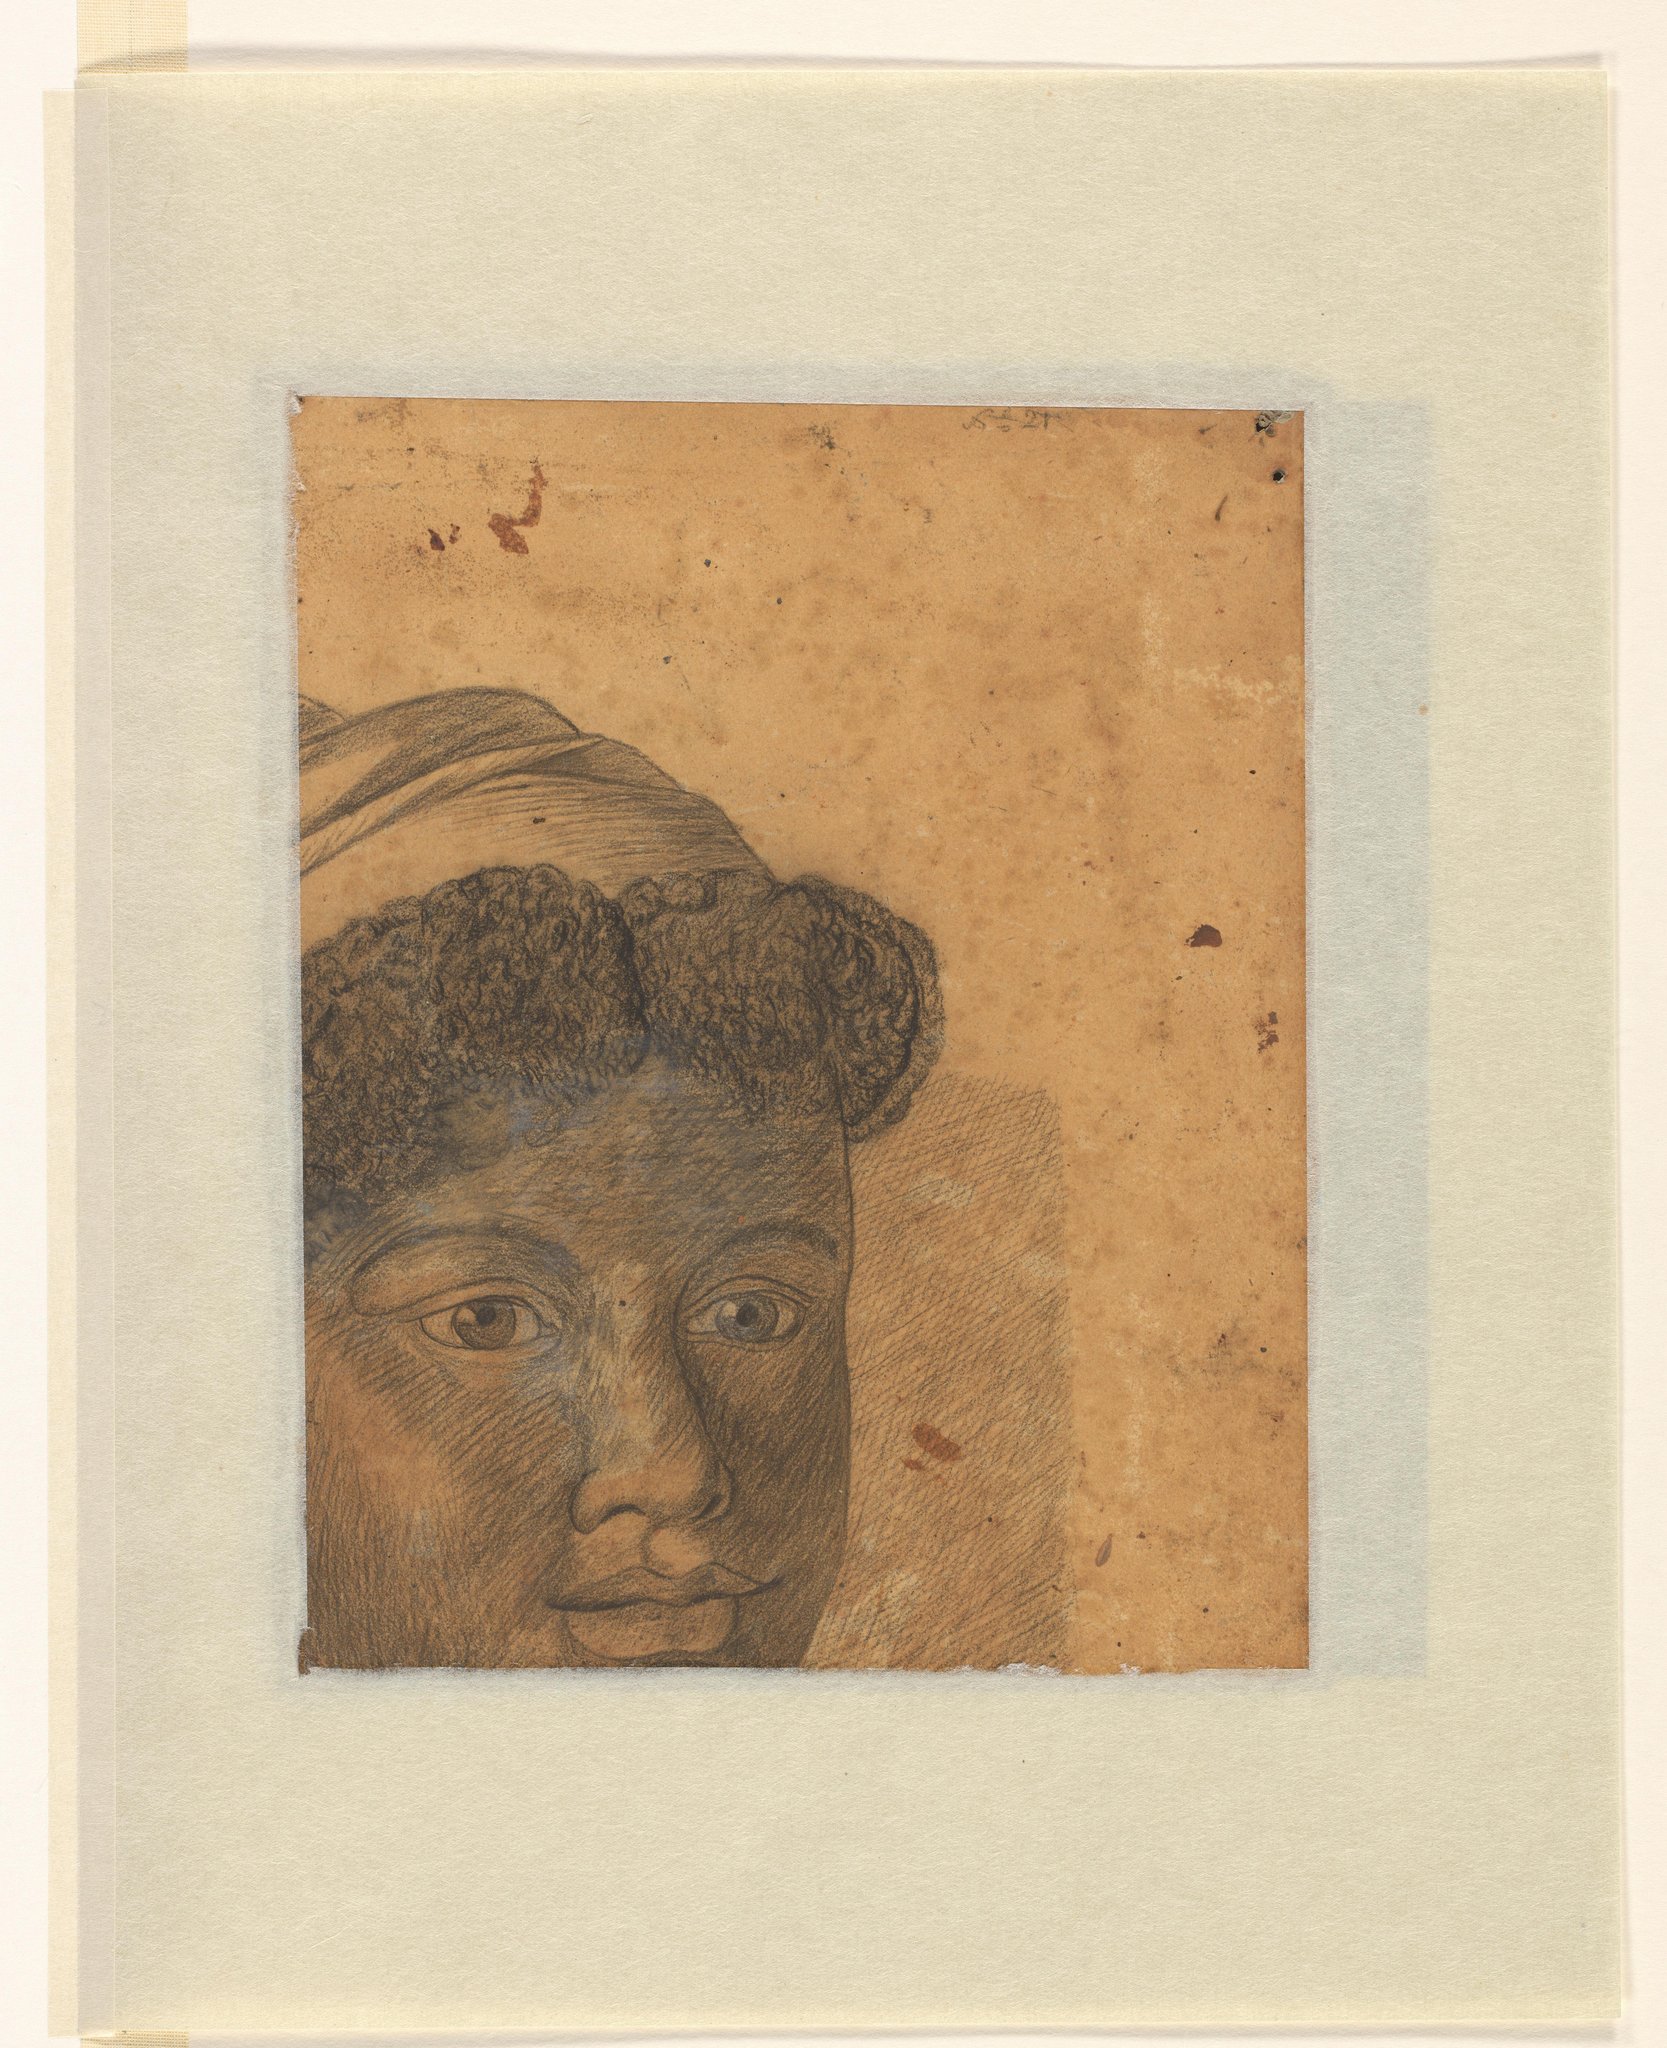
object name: drawing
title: Fragment van een grotere tekening van een zwarte man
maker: jan weissenbruch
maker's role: painter, print maker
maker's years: 1822-1880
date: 1832-1880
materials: chalk, paper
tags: africans